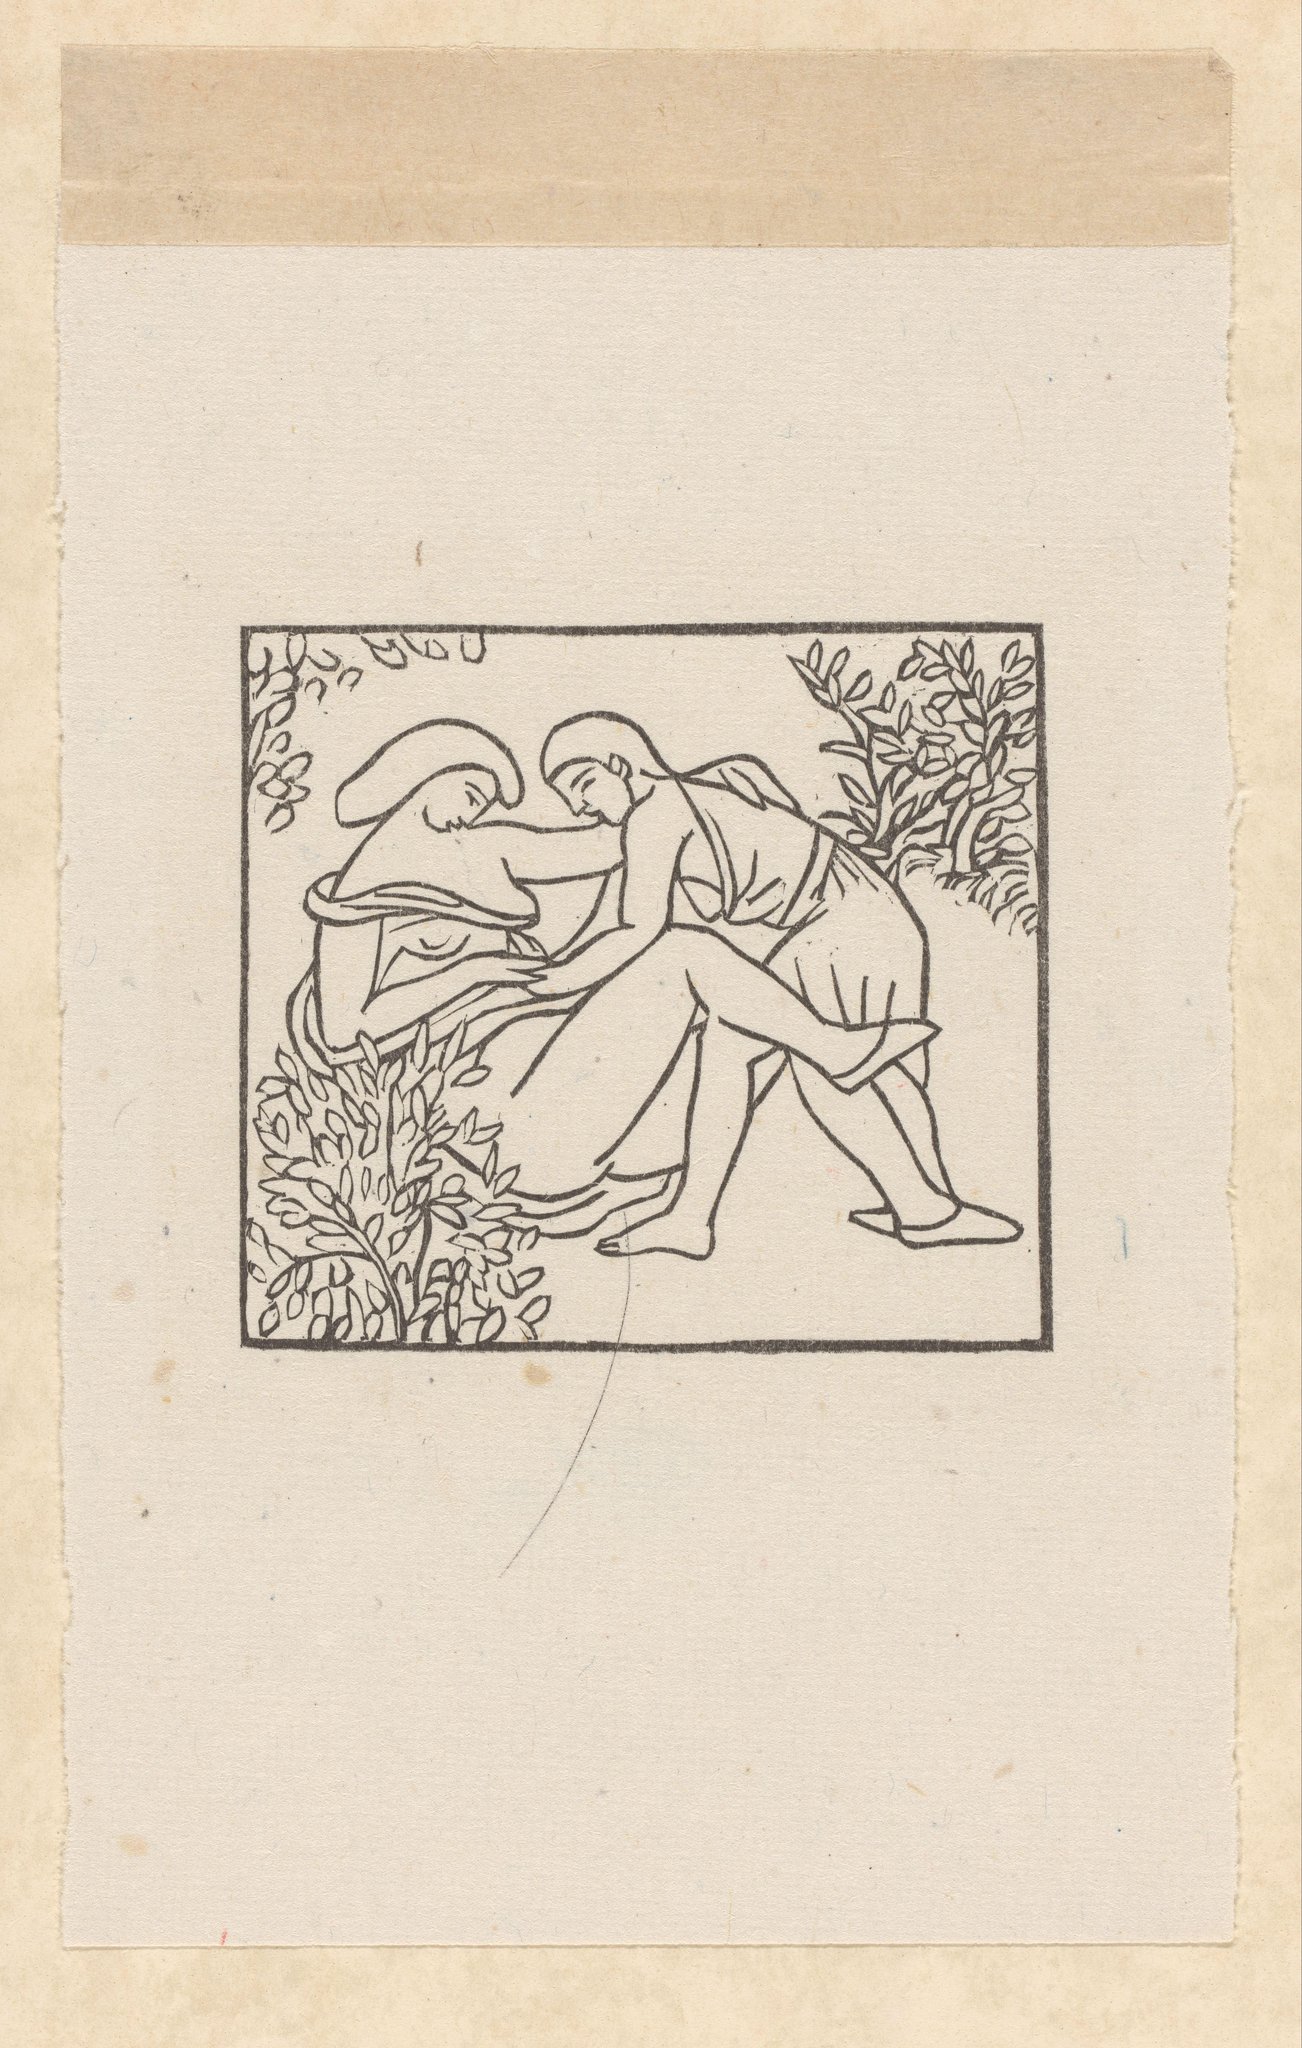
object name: print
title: Lycaenium leert Daphnis hoe te beminnen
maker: aristide maillol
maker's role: draughtsman, painter, print maker, sculptor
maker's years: 1861-1944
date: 1937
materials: paper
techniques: woodcut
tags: daphnis (in greek mythology a shepherd who invented pastoral poetry, chloe, couple of lovers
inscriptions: collector's mark: Lugt 2228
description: Latere staat van deze prent gebruikt in: Longus. Les Pastorales de Longus ou Daphnis & Chloé. Parijs: Frères Gonin, 1935, p. 141.